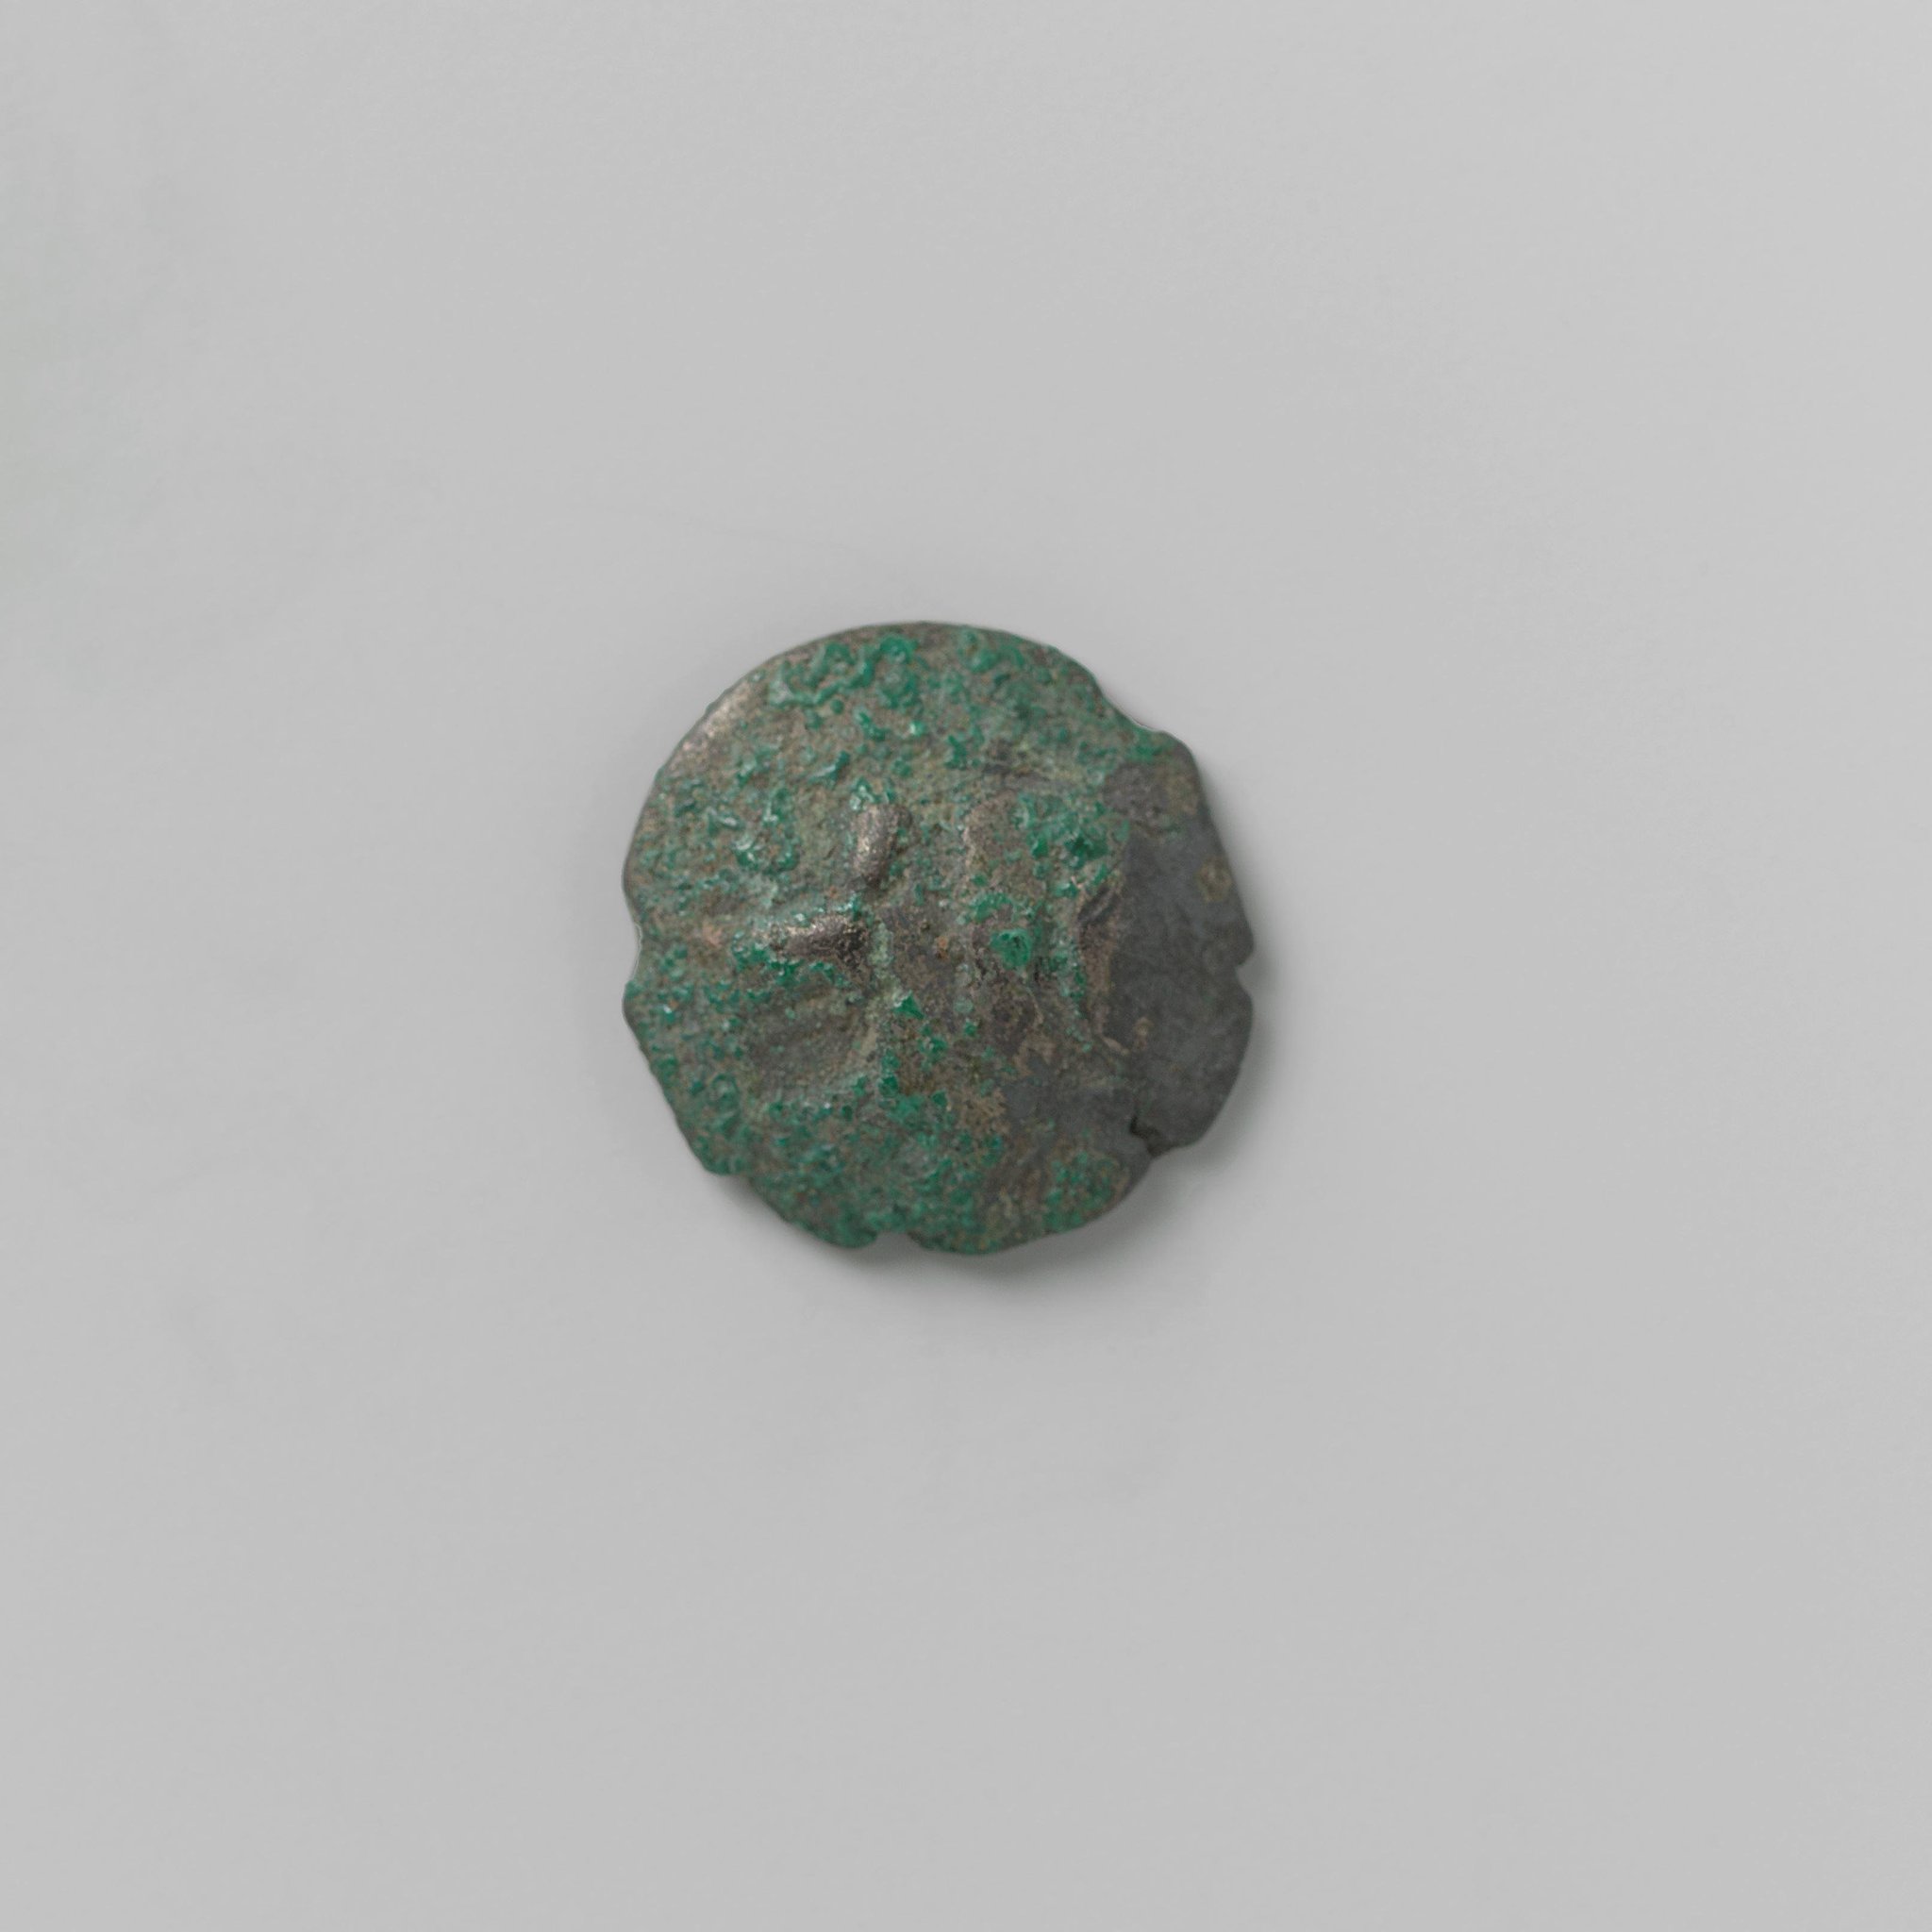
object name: coin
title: Kwart djampel van koninkrijk Majopahit op Java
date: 1290-1520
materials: silver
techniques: striking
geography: java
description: Zilveren schotelvormige munt. Voorzijde: letterteken in devanagari-schrift [maa?]. Keerzijde, figuratie [bloem?].